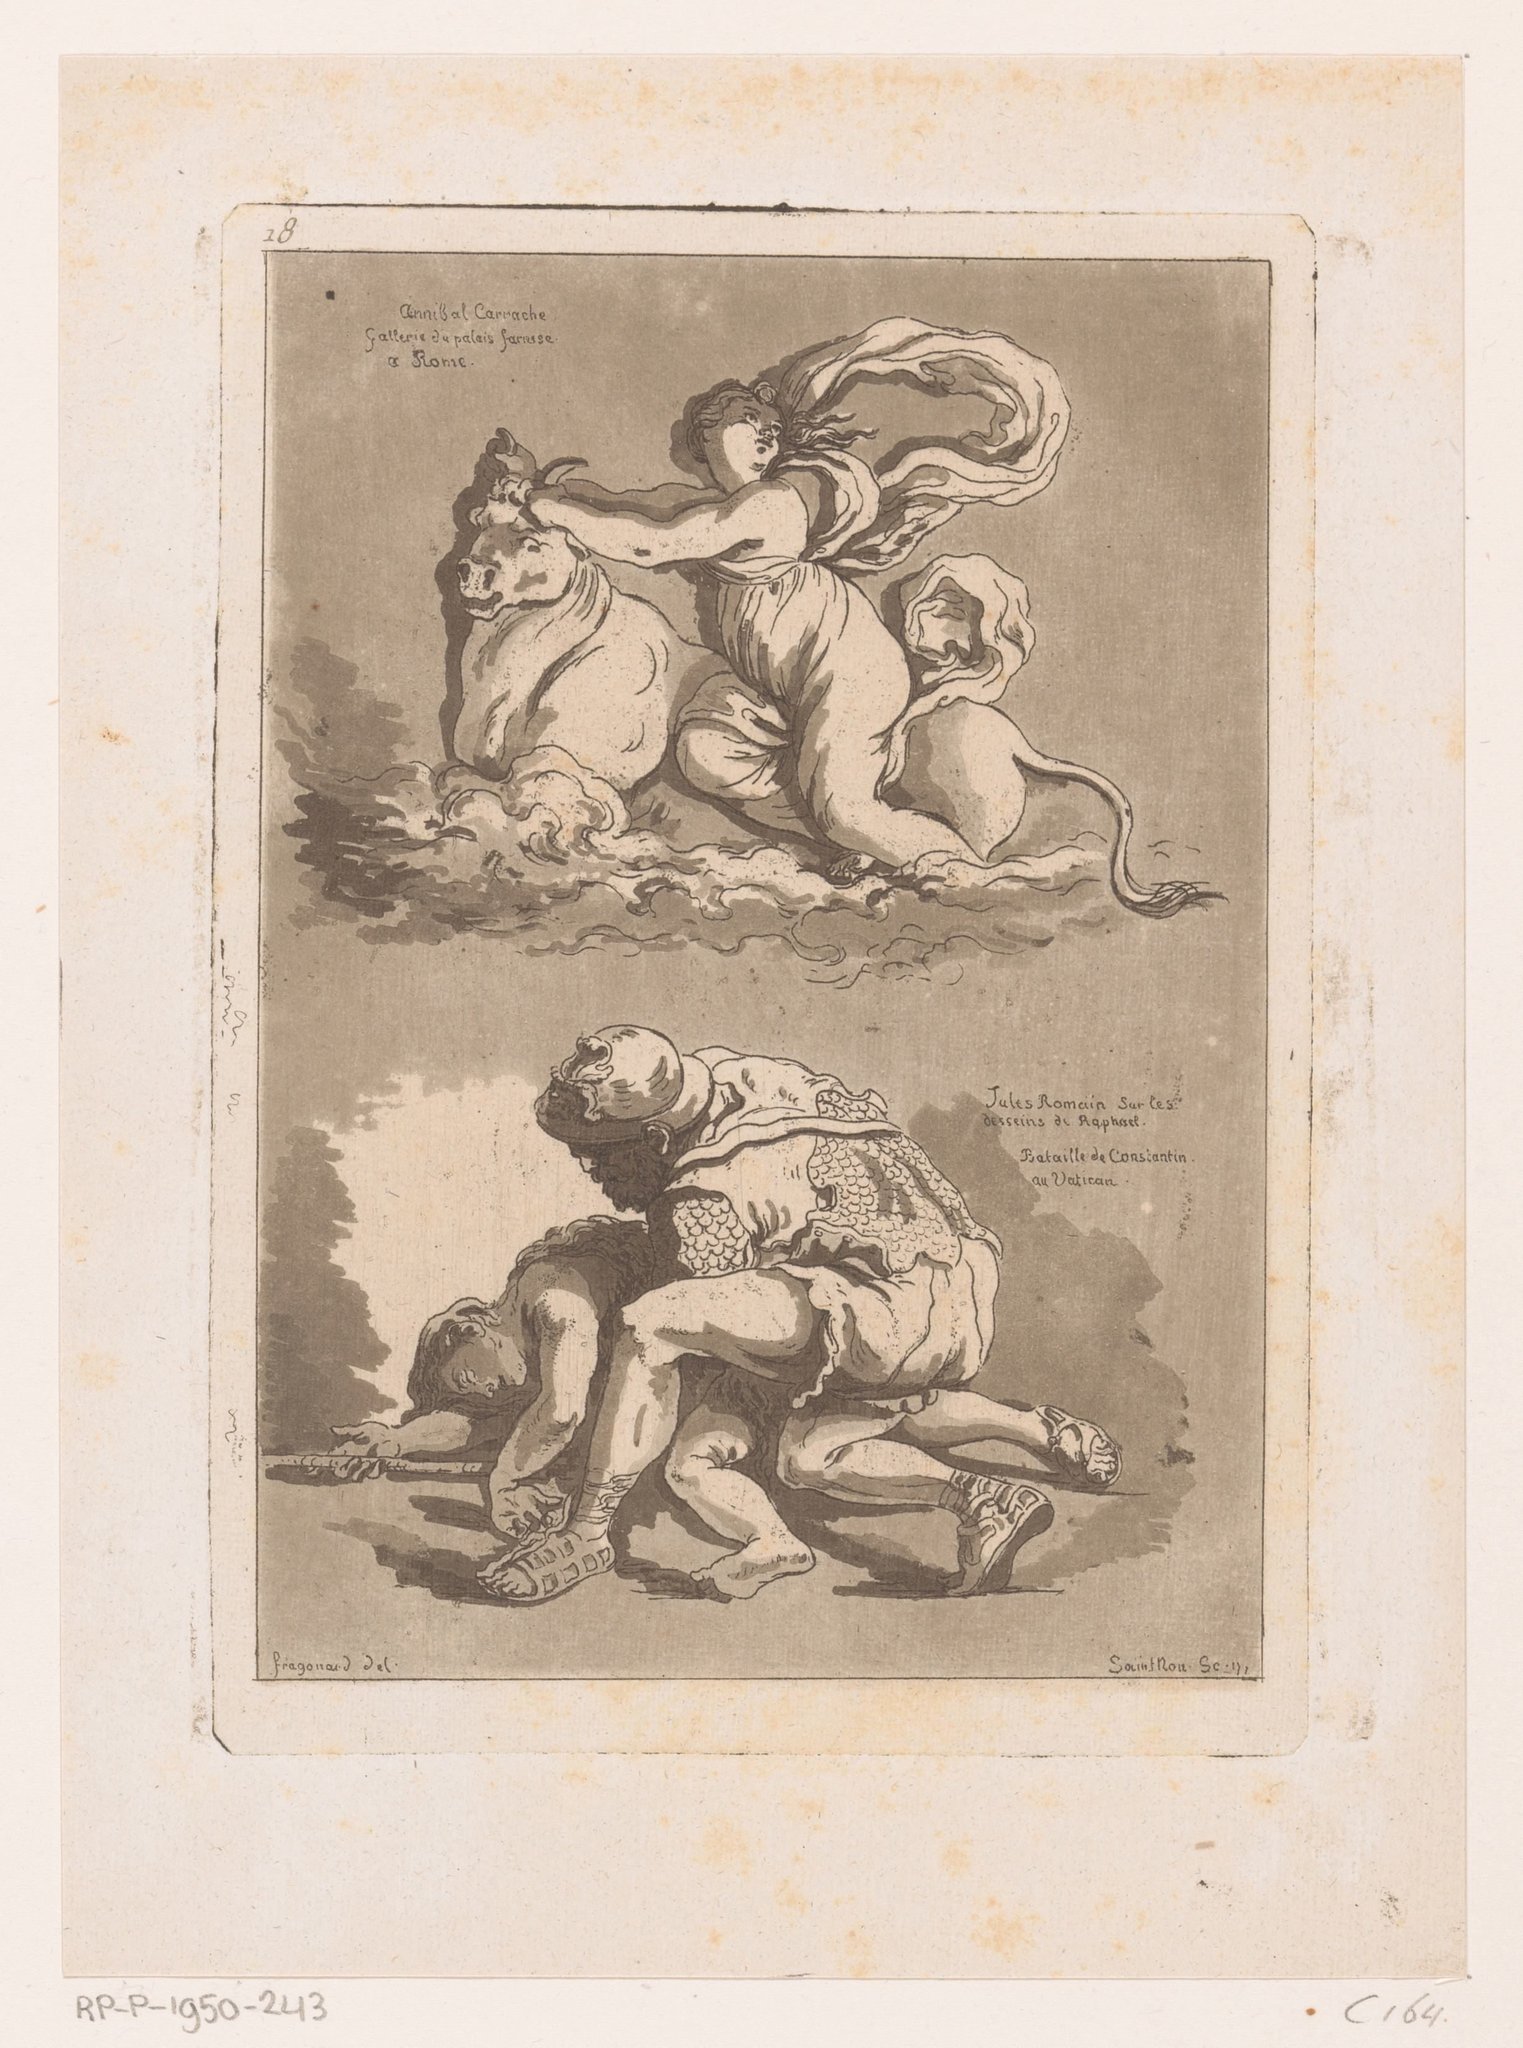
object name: print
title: Fragments choisis dans les peintures et les tableaux les plus intéressants de l'Italie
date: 1771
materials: paper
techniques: aquatint, etching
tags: jupiter, usually in the shape of a white bull, abducts europa and carries her across the water, the battle of the milvian bridge (saxa rubra): st. constantine on horseback confronts maxentius; a cross appears in the sky with in fiery letters 'in hoc signo vinces' (the raised standards of the roman soldiers carry a cross or the chi-rho monogram)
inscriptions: collector's mark: Lugt 2228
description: Prent maakt deel uit van een serie met daarbinnen delen over specifiek Rome, Bologna, Napels en Venetië.